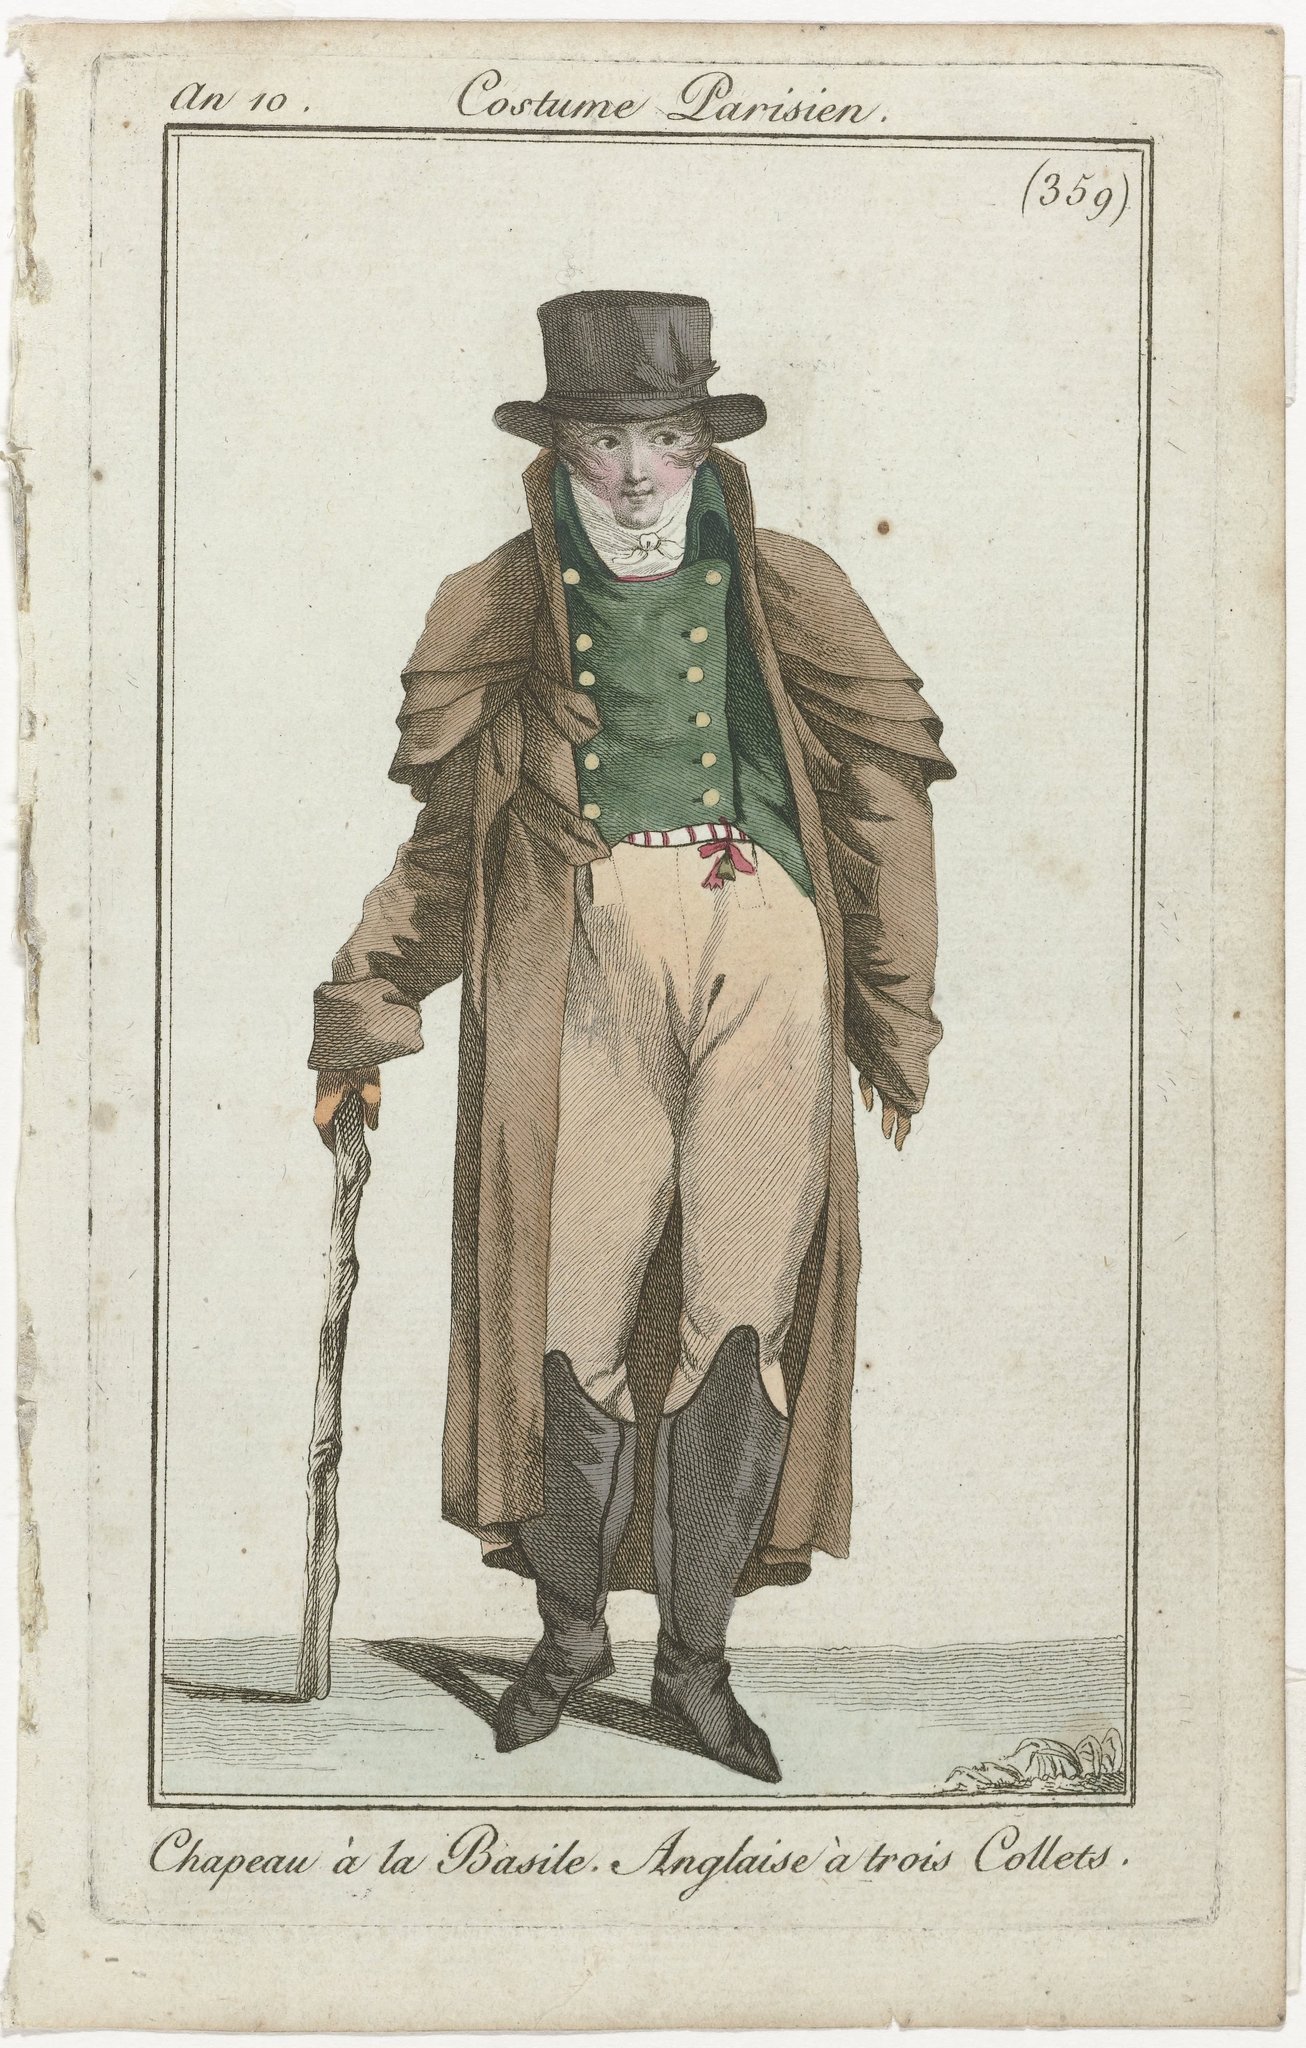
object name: fashion print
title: Journal des Dames et des Modes: Men’s Fashion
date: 1802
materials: paper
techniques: engraving, hand coloring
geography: paris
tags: clothing for the upper part of the body (vest) (+ men's clothes), neck-gear ~ clothing (cravat) (+ men's clothes), trousers, breeches, etc. (pantalon) (+ men's clothes), coat: overcoat (+ men's clothes), coat (frac) (+ men's clothes), coat (carrick) (+ men's clothes), fashion plates, clothes, costume (+ men's clothes), neck-gear: collar (+ men's clothes), gloves, mittens, etc. (+ men's clothes), walking-stick, staff, cane (+ men's clothes)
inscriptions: title: ‘Costume Parisien.’, caption: ‘Chapeau à la Basile. Anglaise à trois Collets.’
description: The Journal des Dames et des Modes occasionally provided coverage of men’s styles. These illustrations give a good picture of trends in mens’ clothing from 1797 to 1825. During the 18th century, gentlemen wore culotte (knee-breeches) 1. These fell out of fashion with the elimination of strict class distinctions during the French Revolution, to be replaced by a type of long trouser(s) known as pantalon à la Hussarde 2. These were worn with hussar boots. ‘Pantaloons’ 3 were trousers pulled tight with an elastic strap under the instep. Carrick 4 coats with a double collar were popular, and in the evenings men wore a special dress cloak 5.